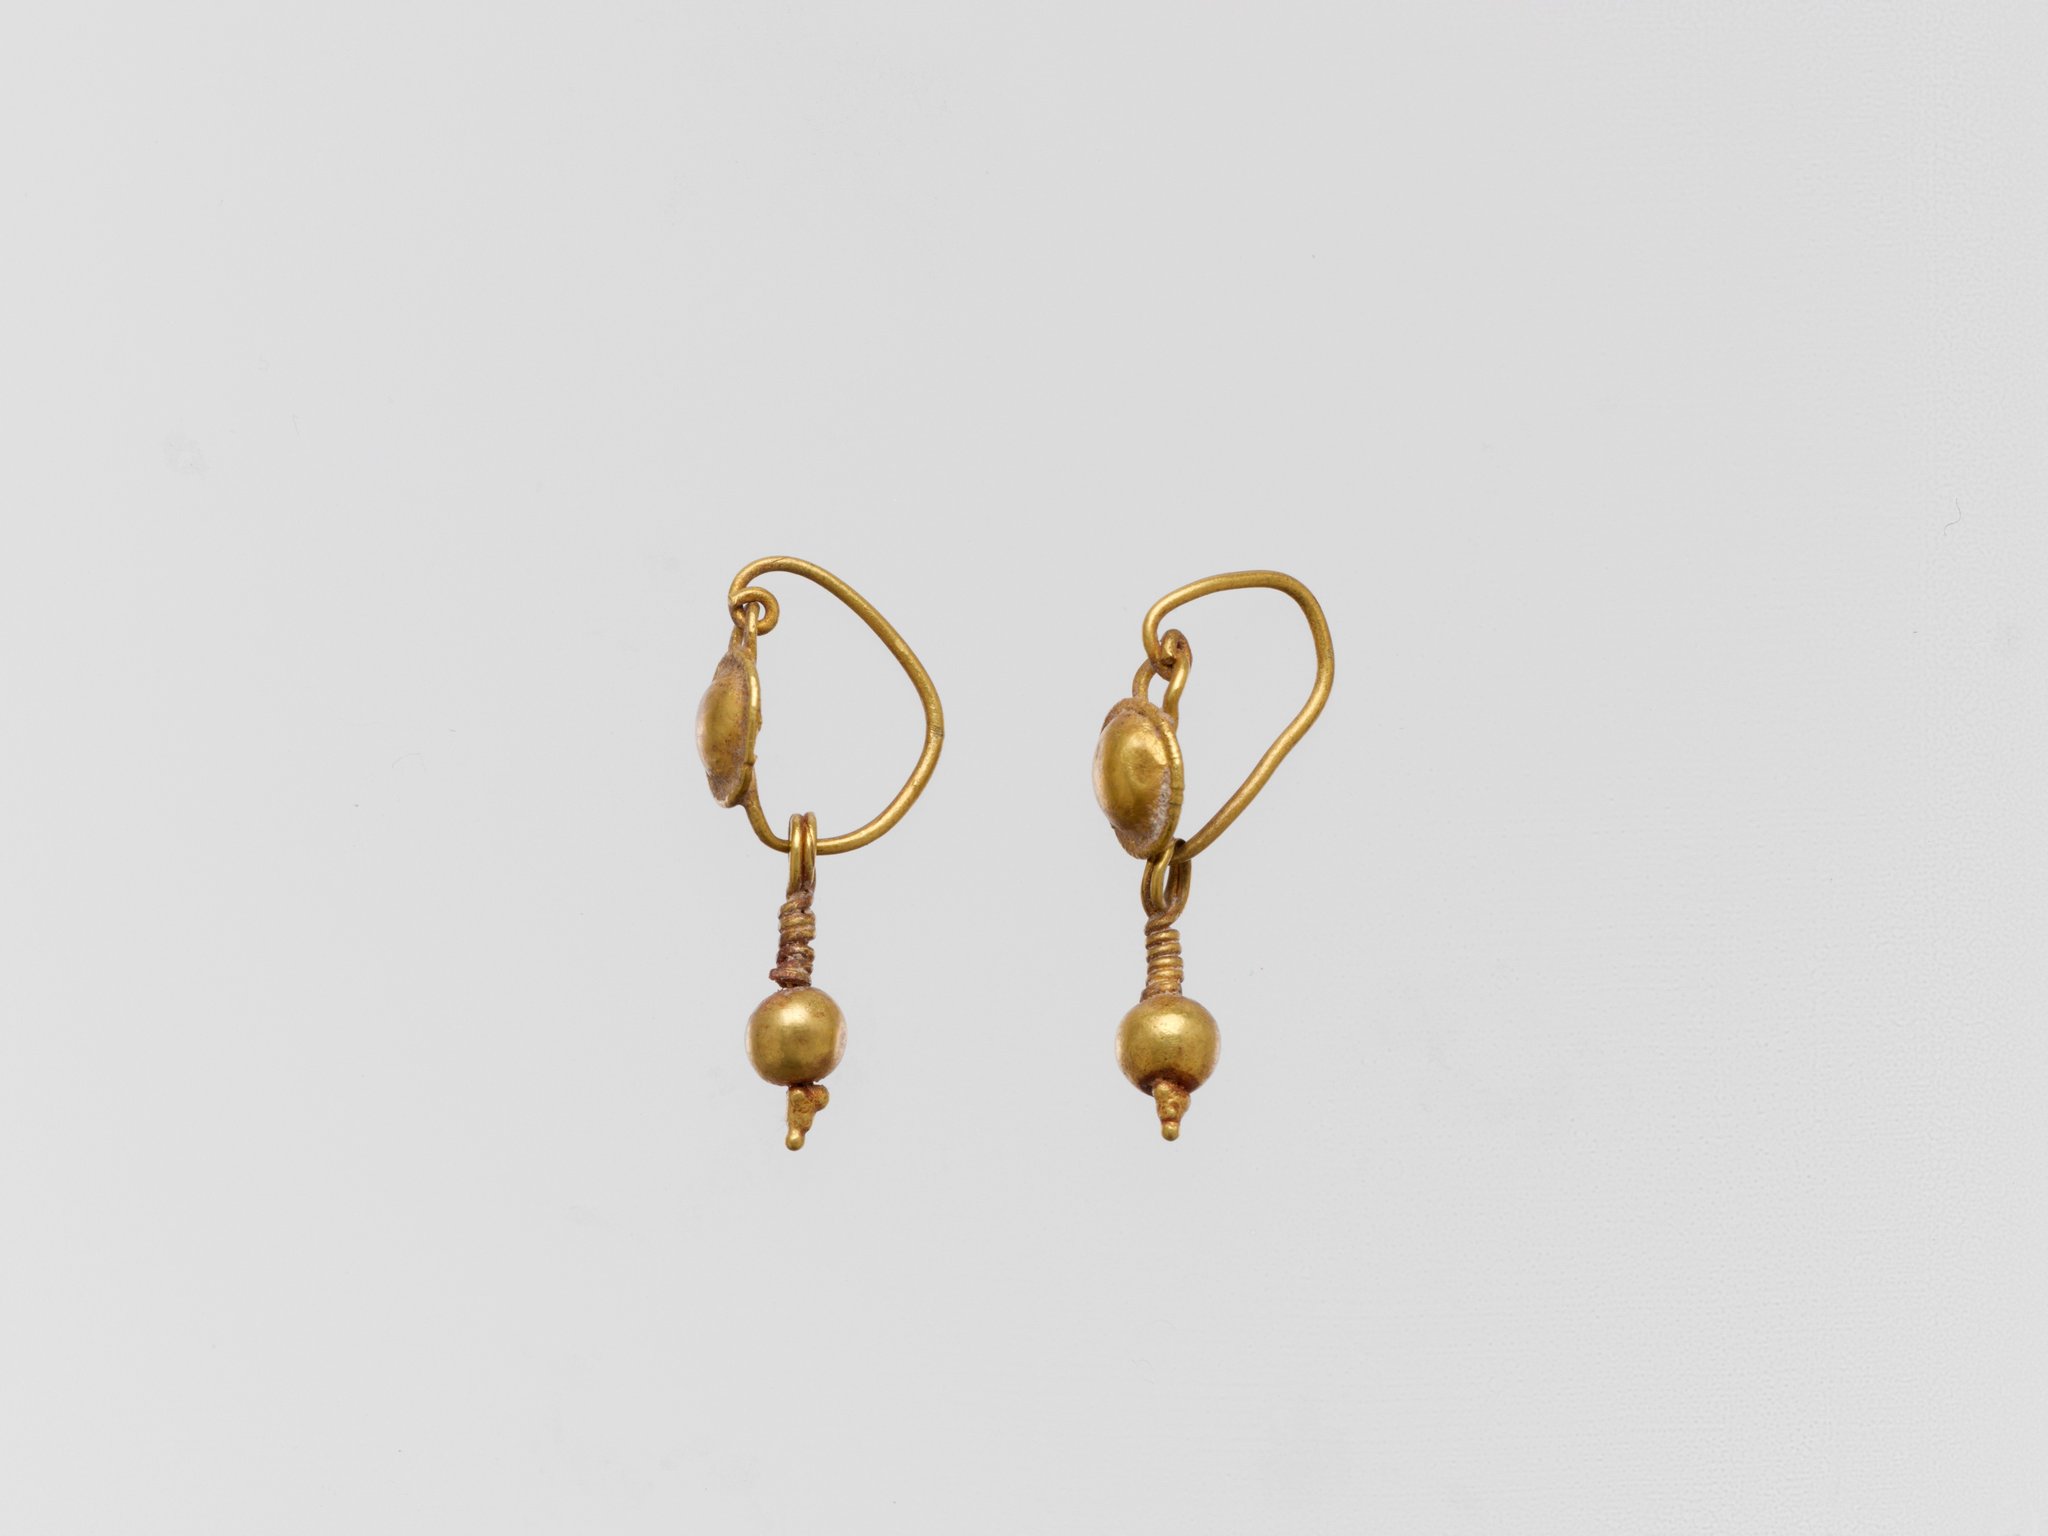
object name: earring with pendant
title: Gold earring with disc and pendant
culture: roman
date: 101-200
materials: gold